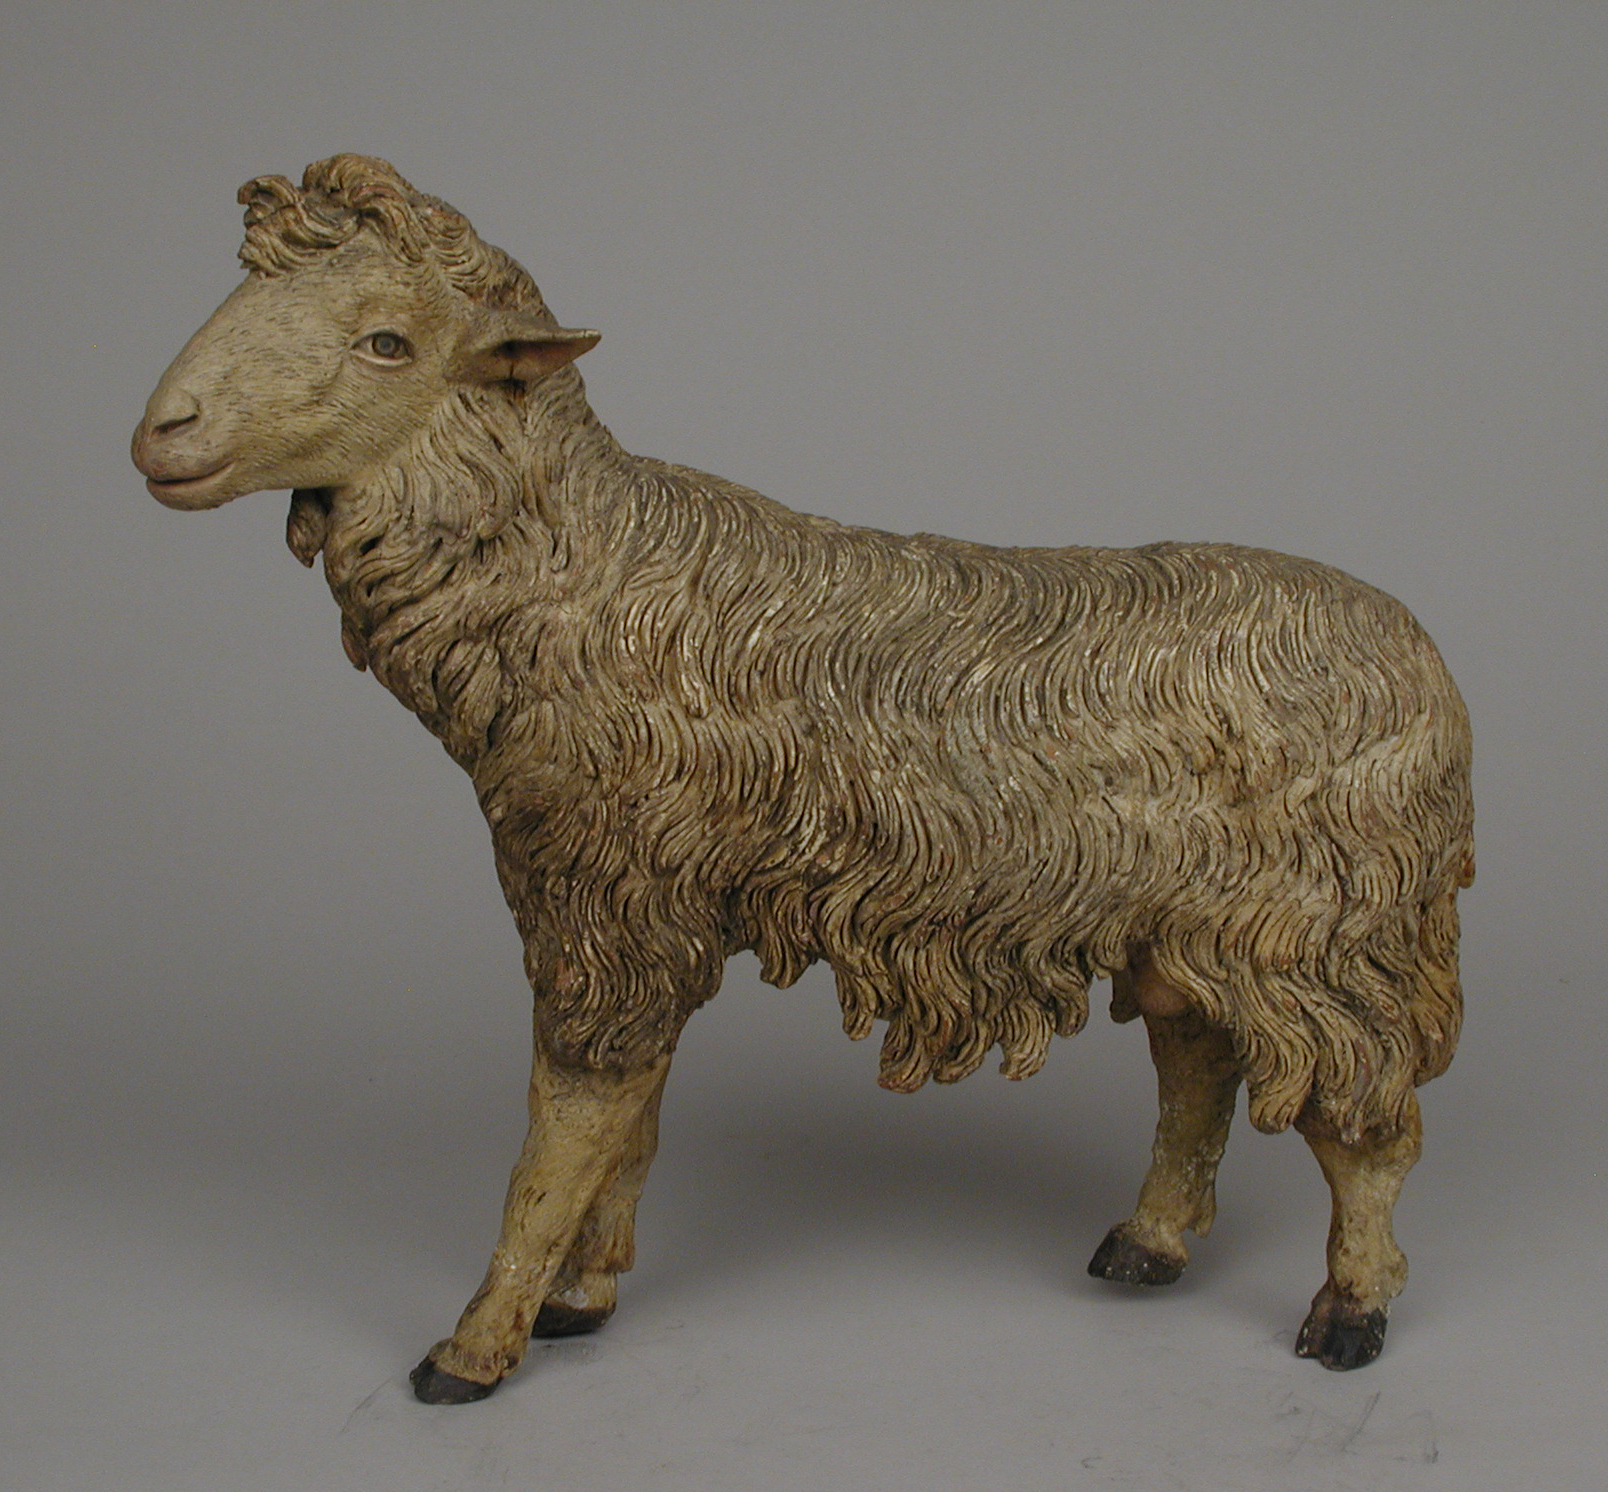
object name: crèche figure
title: Standing sheep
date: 1751-1800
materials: terracotta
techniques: polychrome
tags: sheep